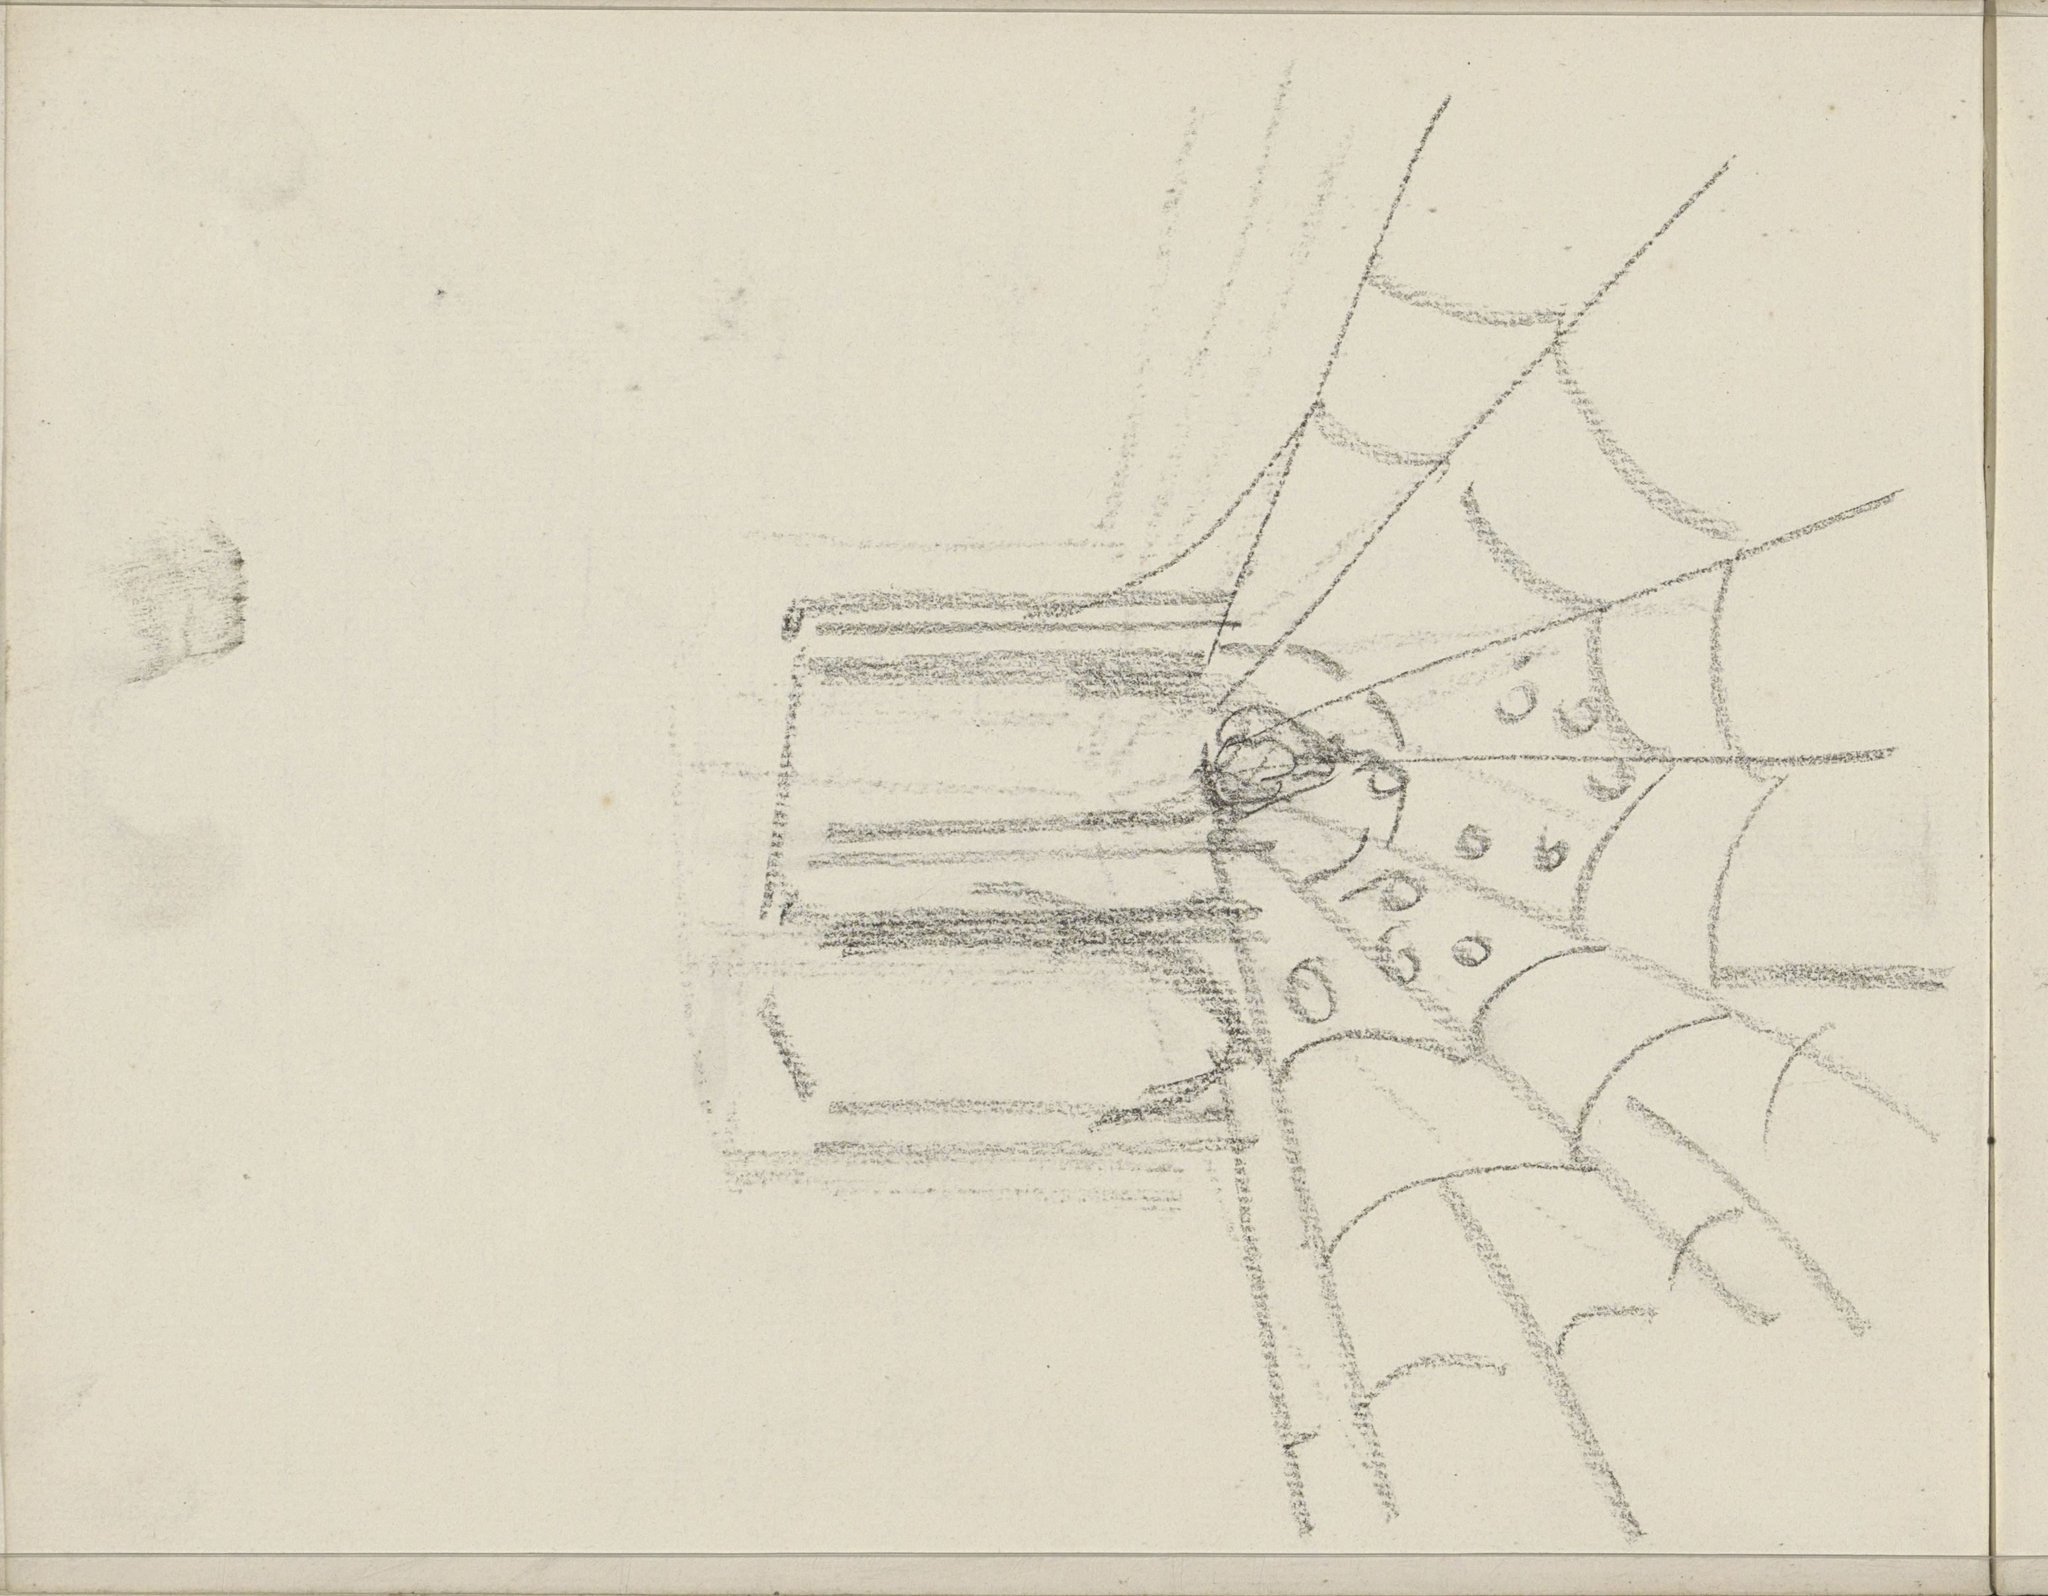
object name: sketchbook leaf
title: Studie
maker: carel adolph lion cachet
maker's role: draughtsman, print maker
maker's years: 1864-1945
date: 1896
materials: chalk, paper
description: Blad 27 verso uit een schetsboek met 44 bladen.